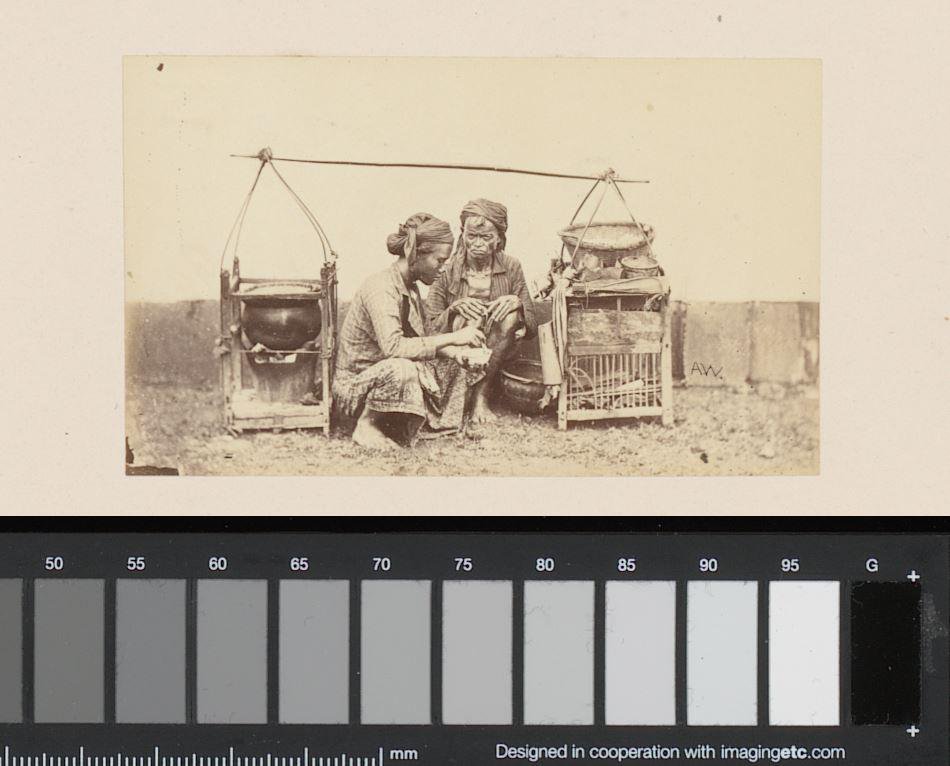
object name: photograph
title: Portret van twee Indonesische vrouwen, hurkend bij een draagstok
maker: Anonymous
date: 1880-1883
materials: photographic support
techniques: albumen print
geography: dutch east indies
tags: carrying something with carrying-pole, adult woman, dutch east indies, the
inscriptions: inscription: ‘AW.’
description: Onderdeel van Reisalbum met opnames van bezienswaardigheden in Egypte, Nederlands-Indië, Singapore en Ceylon.